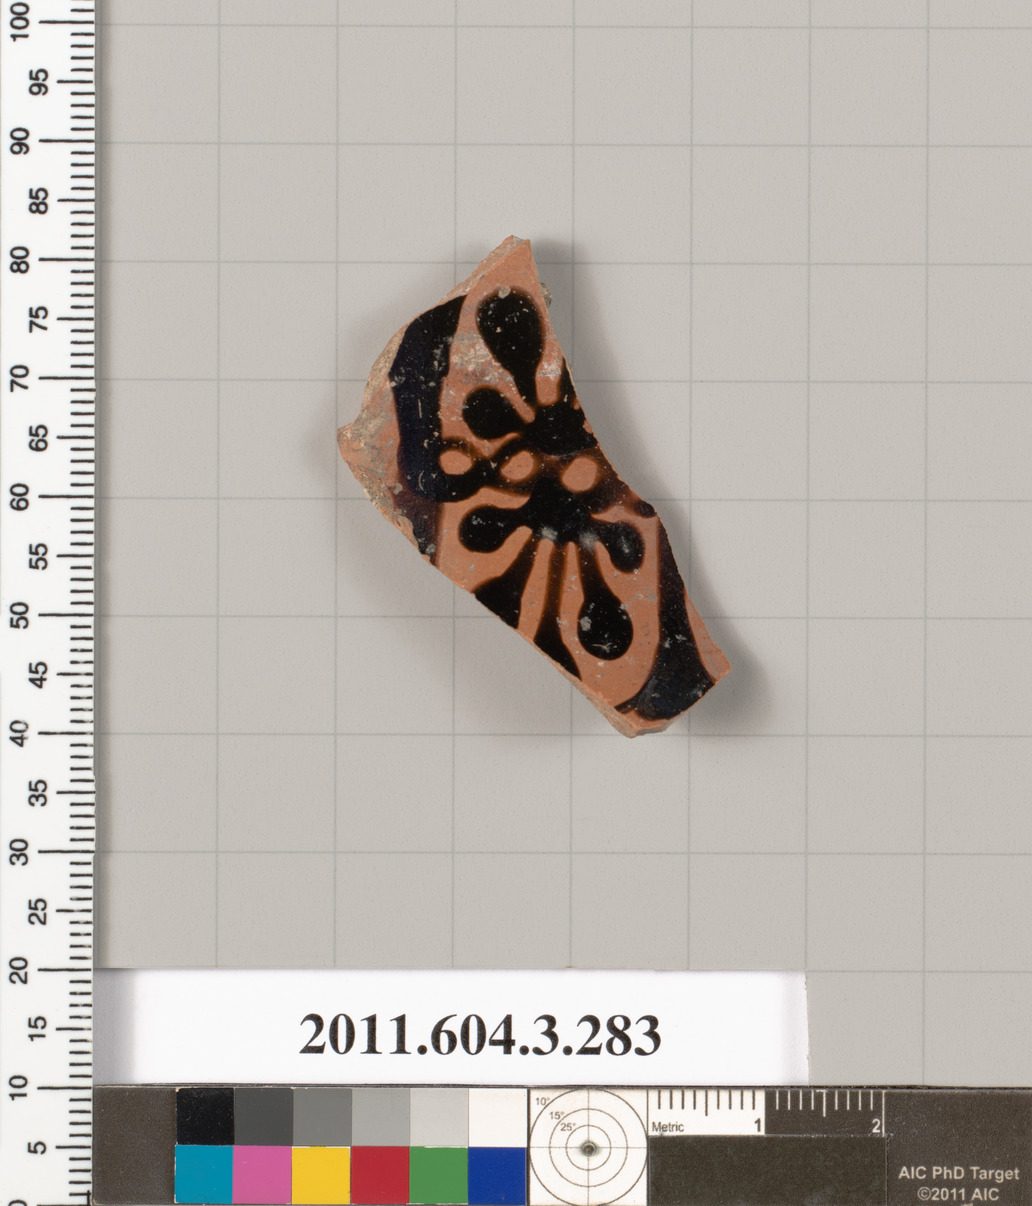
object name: neck amphora fragment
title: Terracotta fragment of a neck-amphora (jar)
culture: greek, attic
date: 520-510 BCE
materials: terracotta